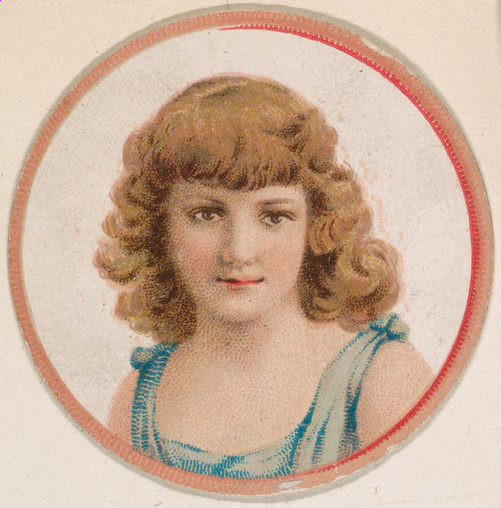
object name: print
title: Portrait of woman, from the Novelties series (N228, Type 2) issued by Kinney Bros.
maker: kinney brothers tobacco company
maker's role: publisher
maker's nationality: american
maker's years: 1869-2011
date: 1889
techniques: color lithograph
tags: portraits,women